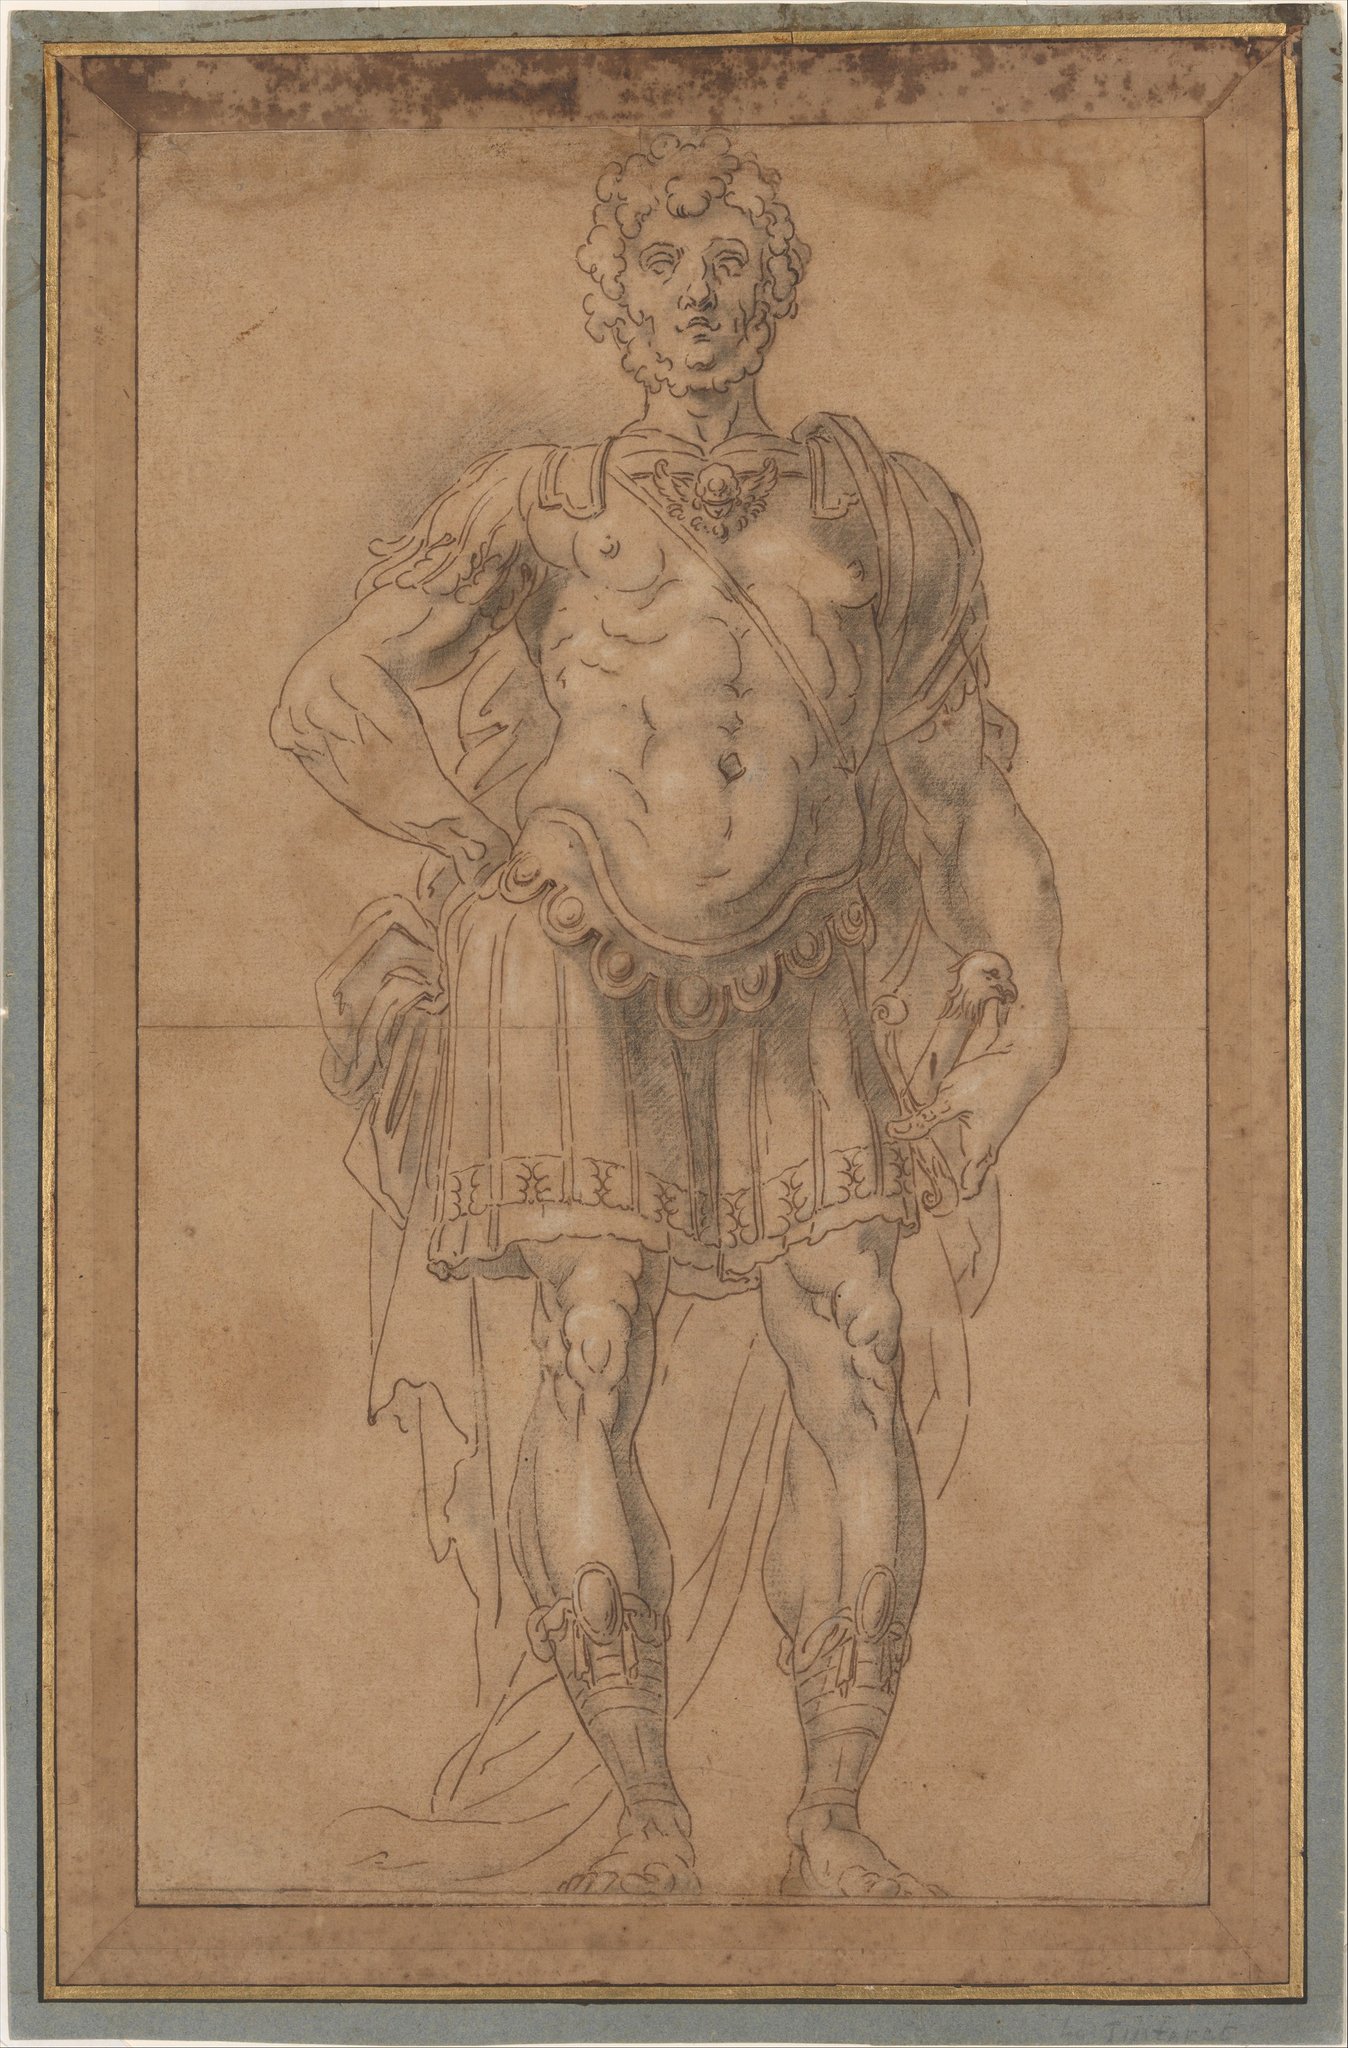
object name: drawing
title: A King of Judah and Israel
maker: martin fréminet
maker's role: artist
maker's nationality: french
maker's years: 1567-1619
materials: chalk, ink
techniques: heightening, pen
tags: kings,men